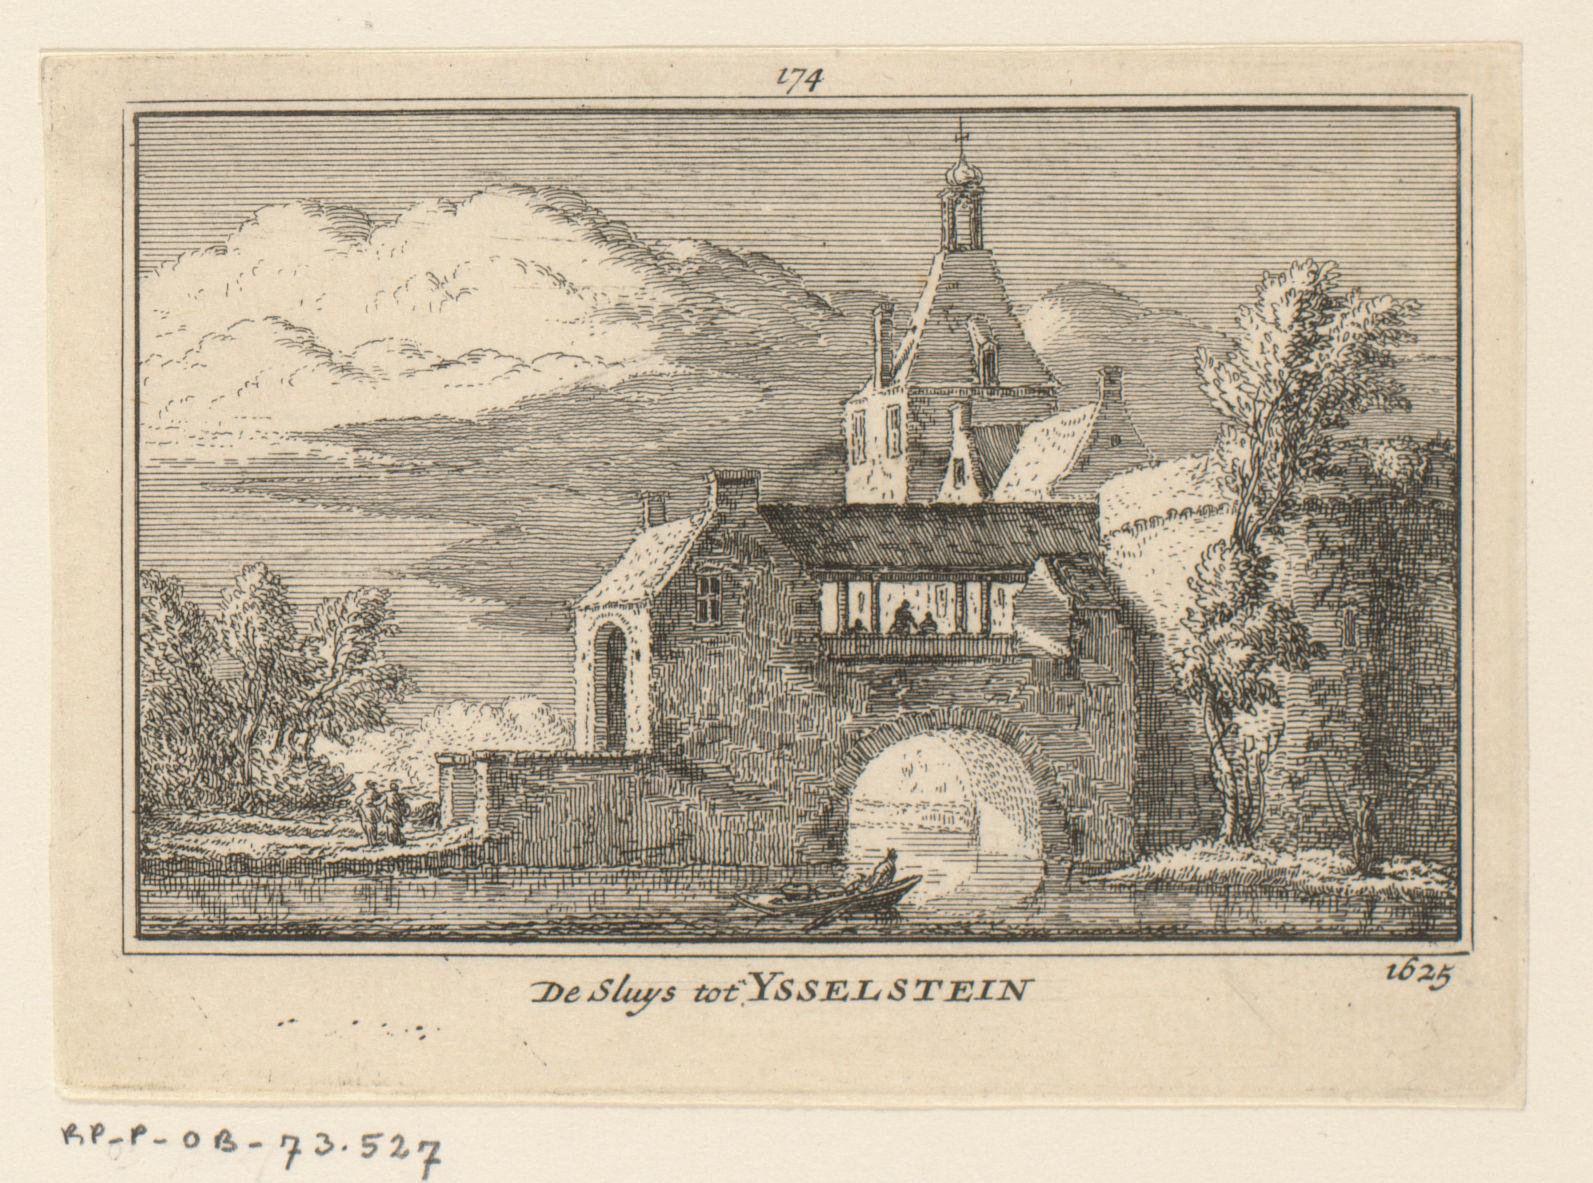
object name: print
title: De sluys tot Ysselstein 1625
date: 1727-1733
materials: paper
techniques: etching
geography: amsterdam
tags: rowing-boat, canoe, etc., lift-lock, canal lock, city-gate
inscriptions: collector's mark: Lugt 2228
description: Illustratie uit: Abraham Rademaker, Matthaeus Brouërius van Niedek, Isaac Le Long, Kabinet van Nederlandsche en Kleefsche outheden en (...) voorname stads- en landgebouwen, Willem Barents en Antoni Schoonenburg: Amsterdam, 1727-1733, ill. nr. 174.